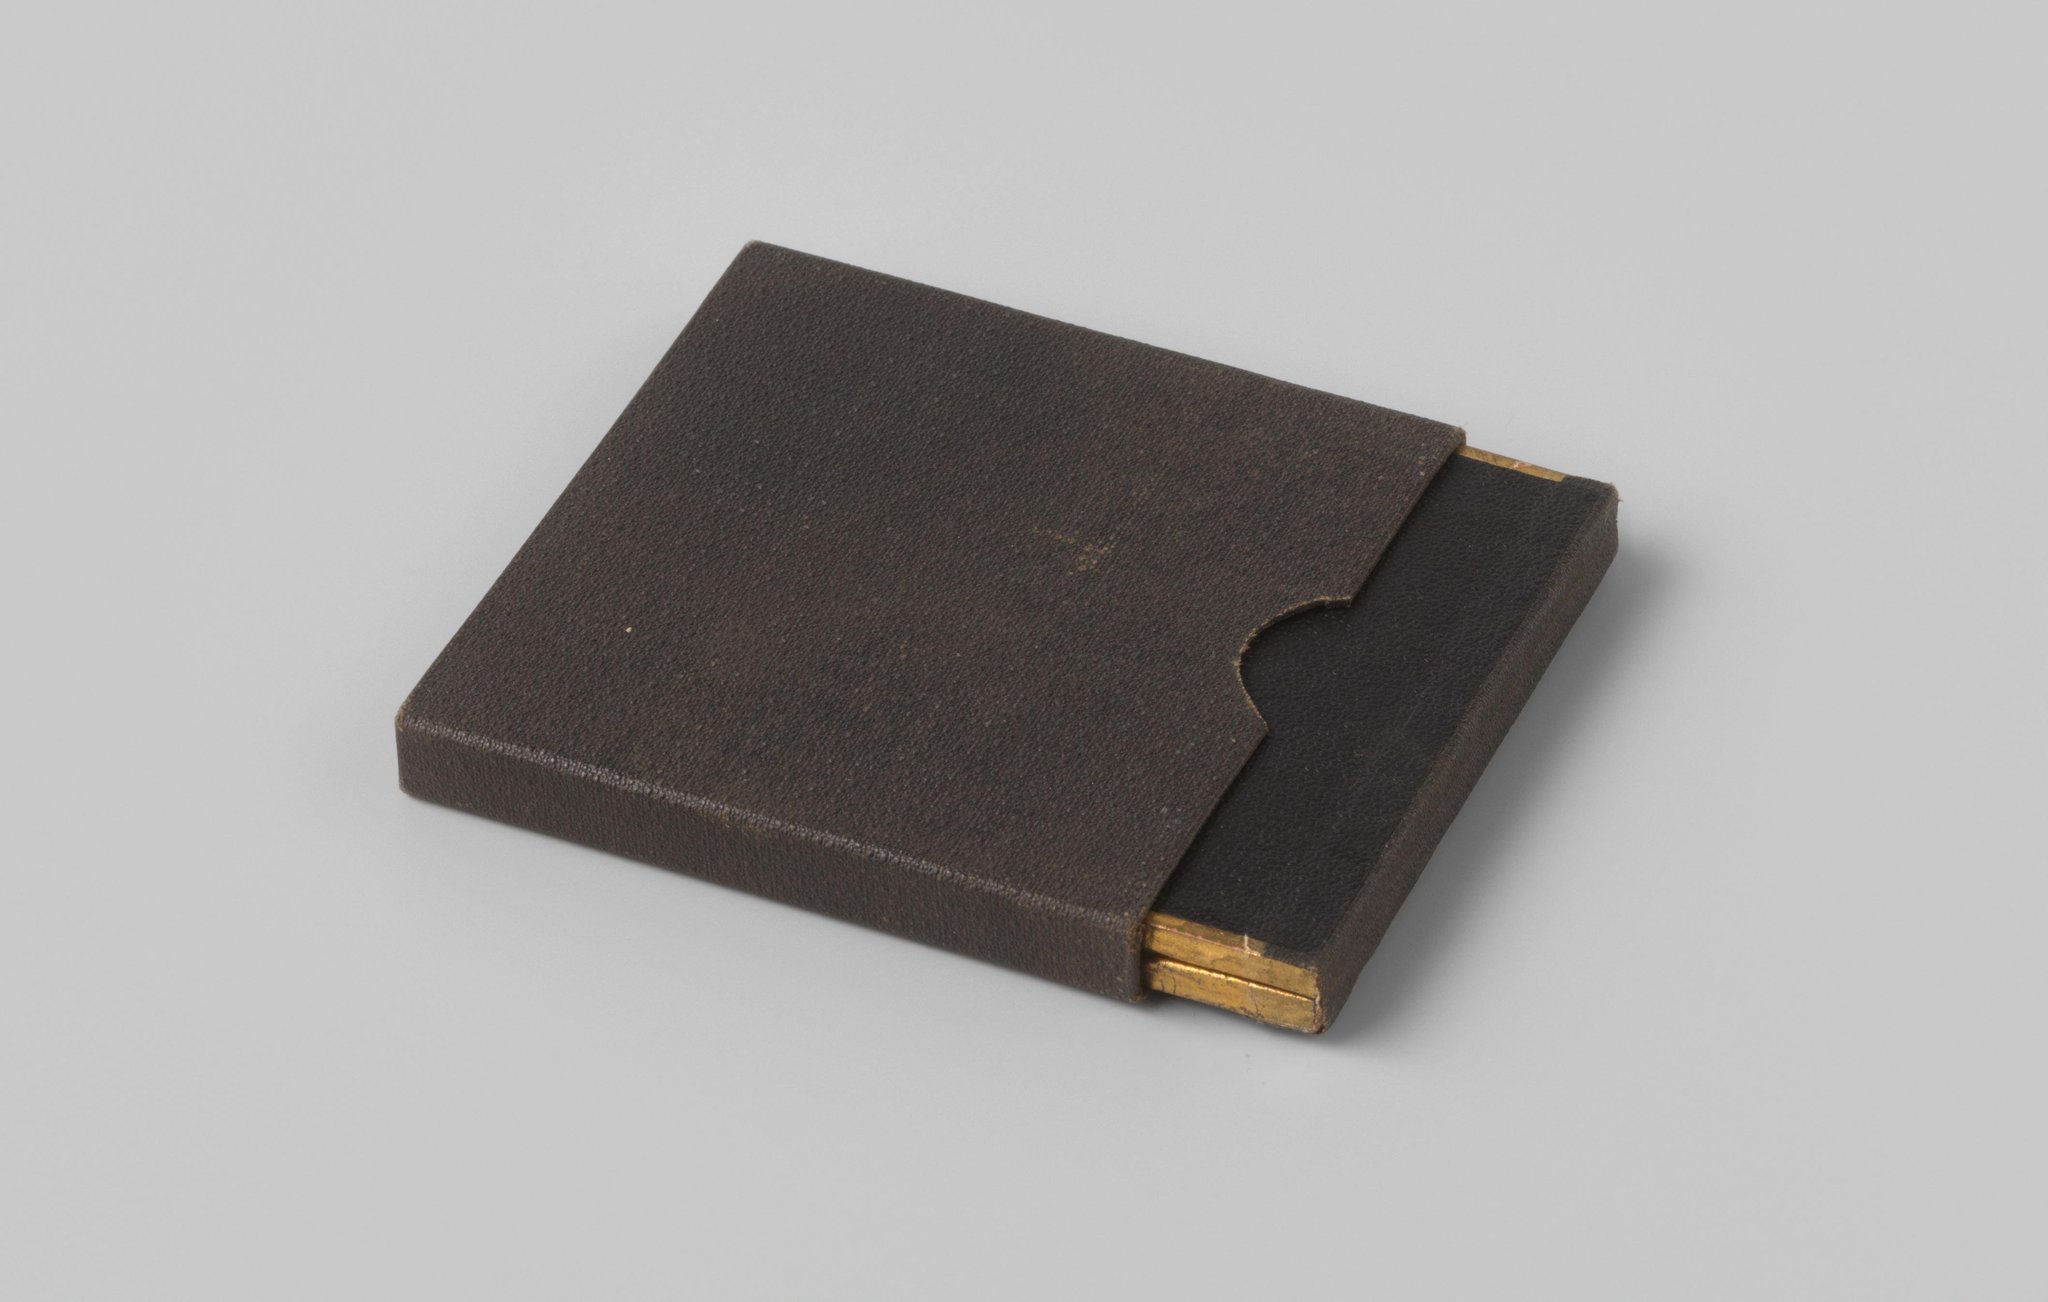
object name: covering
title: Doos behorend bij een bronzen penning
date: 1888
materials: cardboard, velvet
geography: netherlands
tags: utrecht, netherlands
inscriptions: date